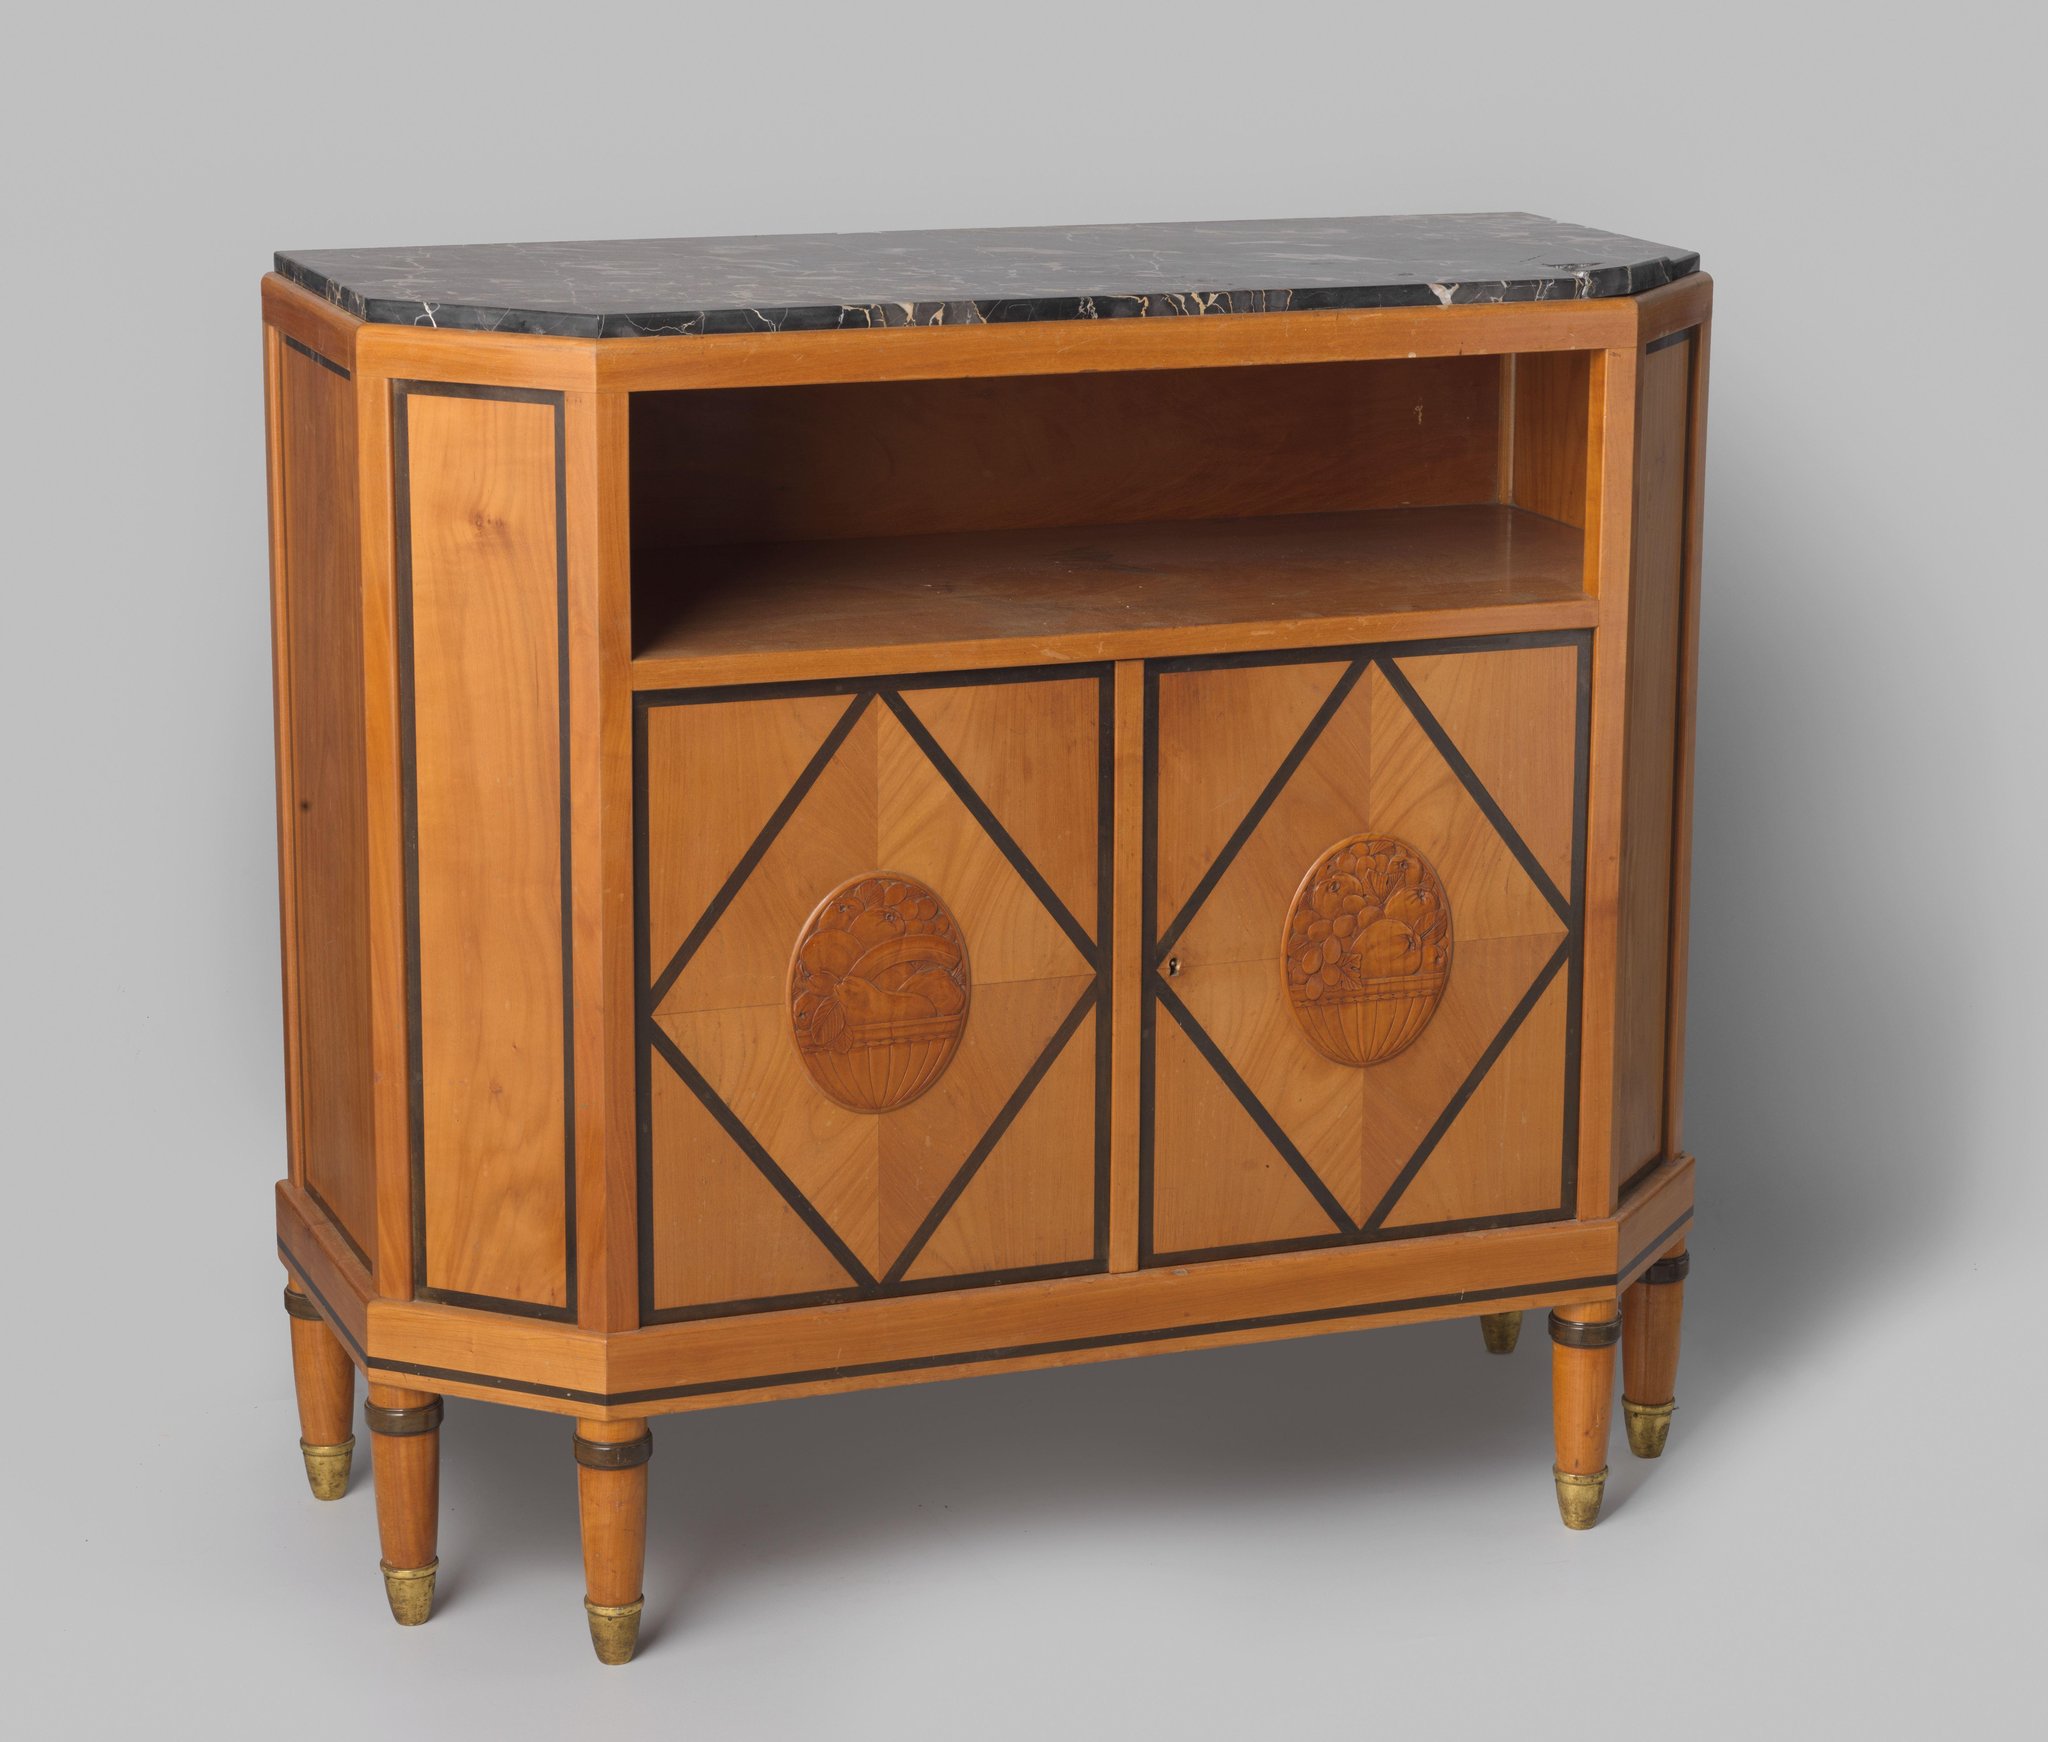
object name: furniture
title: Dressoir met twee deuren waarop medaillons met daarbinnen een gesneden fruitmand omrand met zwarte biezen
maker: Anonymous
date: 1900-1925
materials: brass, wood, marble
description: Dressoir vervaardigd uit vruchtenhout. Het zeskantig dressoir heeft afgeschuinde hoeken aan de voorzijde en rust op zes hoge poten. De gedraaide poten, met aan de onderzijde een messing omhulsel, verbreden naar boven en hebben aan de bovenzijde een zwart geverfde band. Vijf zijden, behalve de achterzijde, bestaan uit een raamwerk met een paneel omgeven door een zwart geverfde bies. De voorzijde bevat twee deuren met daarboven een brede lade waarvan de randen zijn afgezet met een zwart geverfde bies. In het midden van de deuren is een medaillon aangebracht waarbinnen een gesneden fruitmand. Daar omheen is een zwart geverfde bies in een ruitvorm. De lade bevat een messing ring als handgreep. Op de bovenzijde van het dressoir is een grijs geaderd marmeren blad ingelaten.